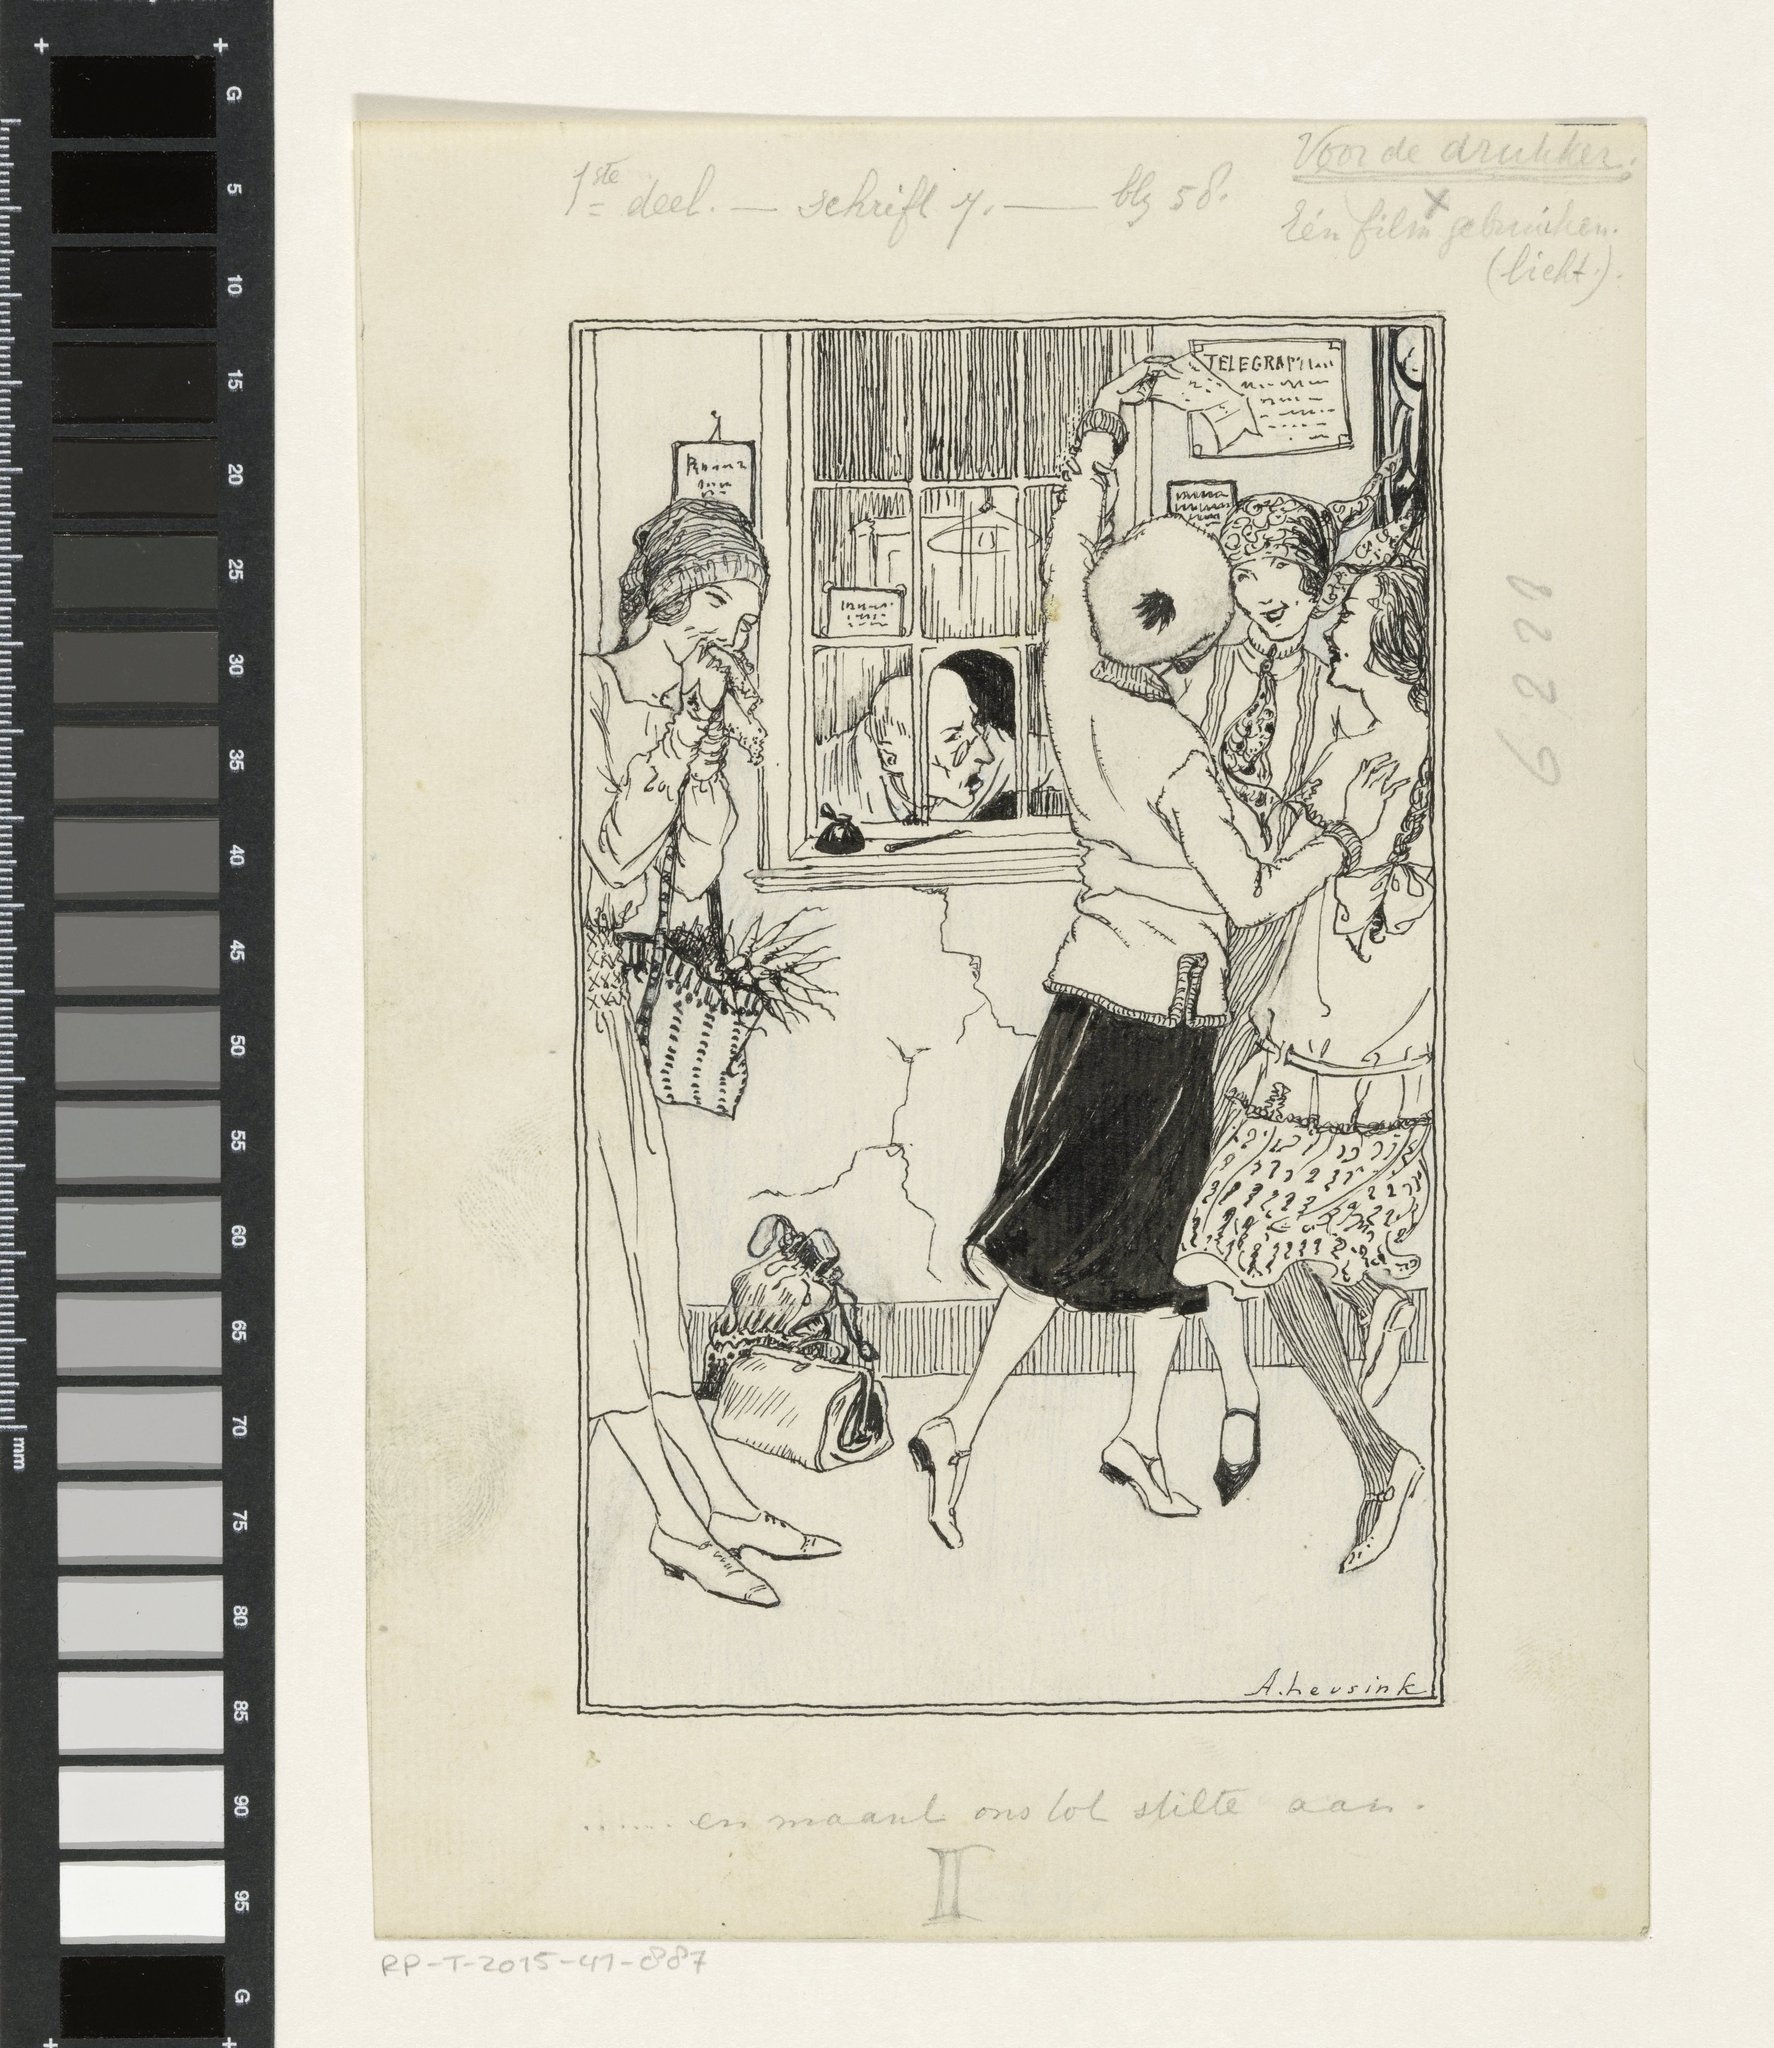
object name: drawing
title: Drie meisjes dansen voor een postkantoor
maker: anny leusink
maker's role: draughtsman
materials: paint, ink, paper, pencil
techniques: brush, pen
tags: post-office, dancing, letter, envelope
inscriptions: :, annotation: ‘1ste deel_schrift 7._blz 58./ ... en maant ons lol stilte aan./ II’, signature: ‘A. Leusink’, collector's mark: Lugt 2228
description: Drie meisjes dansen arm in arm in de rondte voor het loket van een postkantoor. Eén van hen wappert met een brief in de lucht. Een vierde meisje kijkt al proestend in haar zakdoek toe. De loketbediende kijkt geïrriteerd door het loket naar de meisjes.